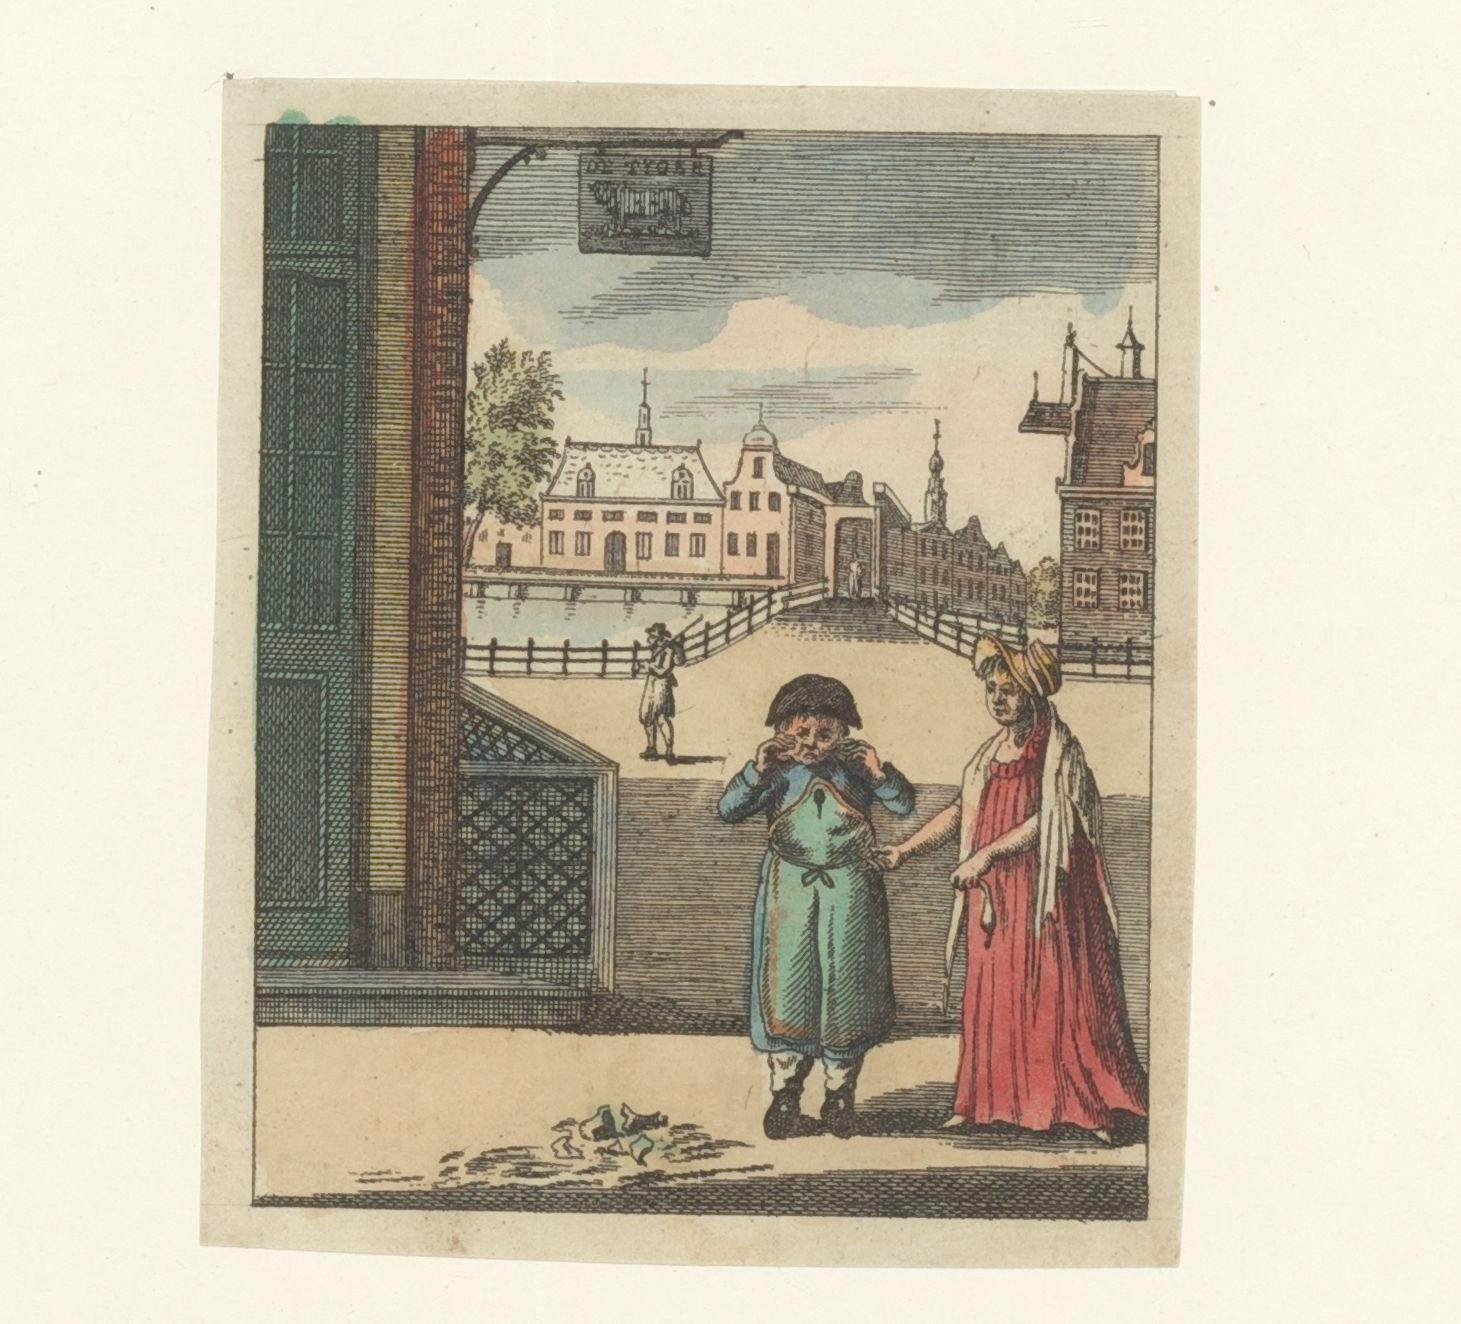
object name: print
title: Jongen huilt bij een gebroken schaal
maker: Anonymous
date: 1800-1899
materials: paper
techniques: etching, hand coloring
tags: boy (child between toddler and youth), weeping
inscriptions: collector's mark: Lugt 1641, stamp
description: Onderwerpsrubrieken binnen de Atlas Zeden en Gewoonten: Zeden en Gewoonten in Engeren Zin, Des menschen beging, midden en einde, Kinderleven – Kinderspel en Kinderprenten.